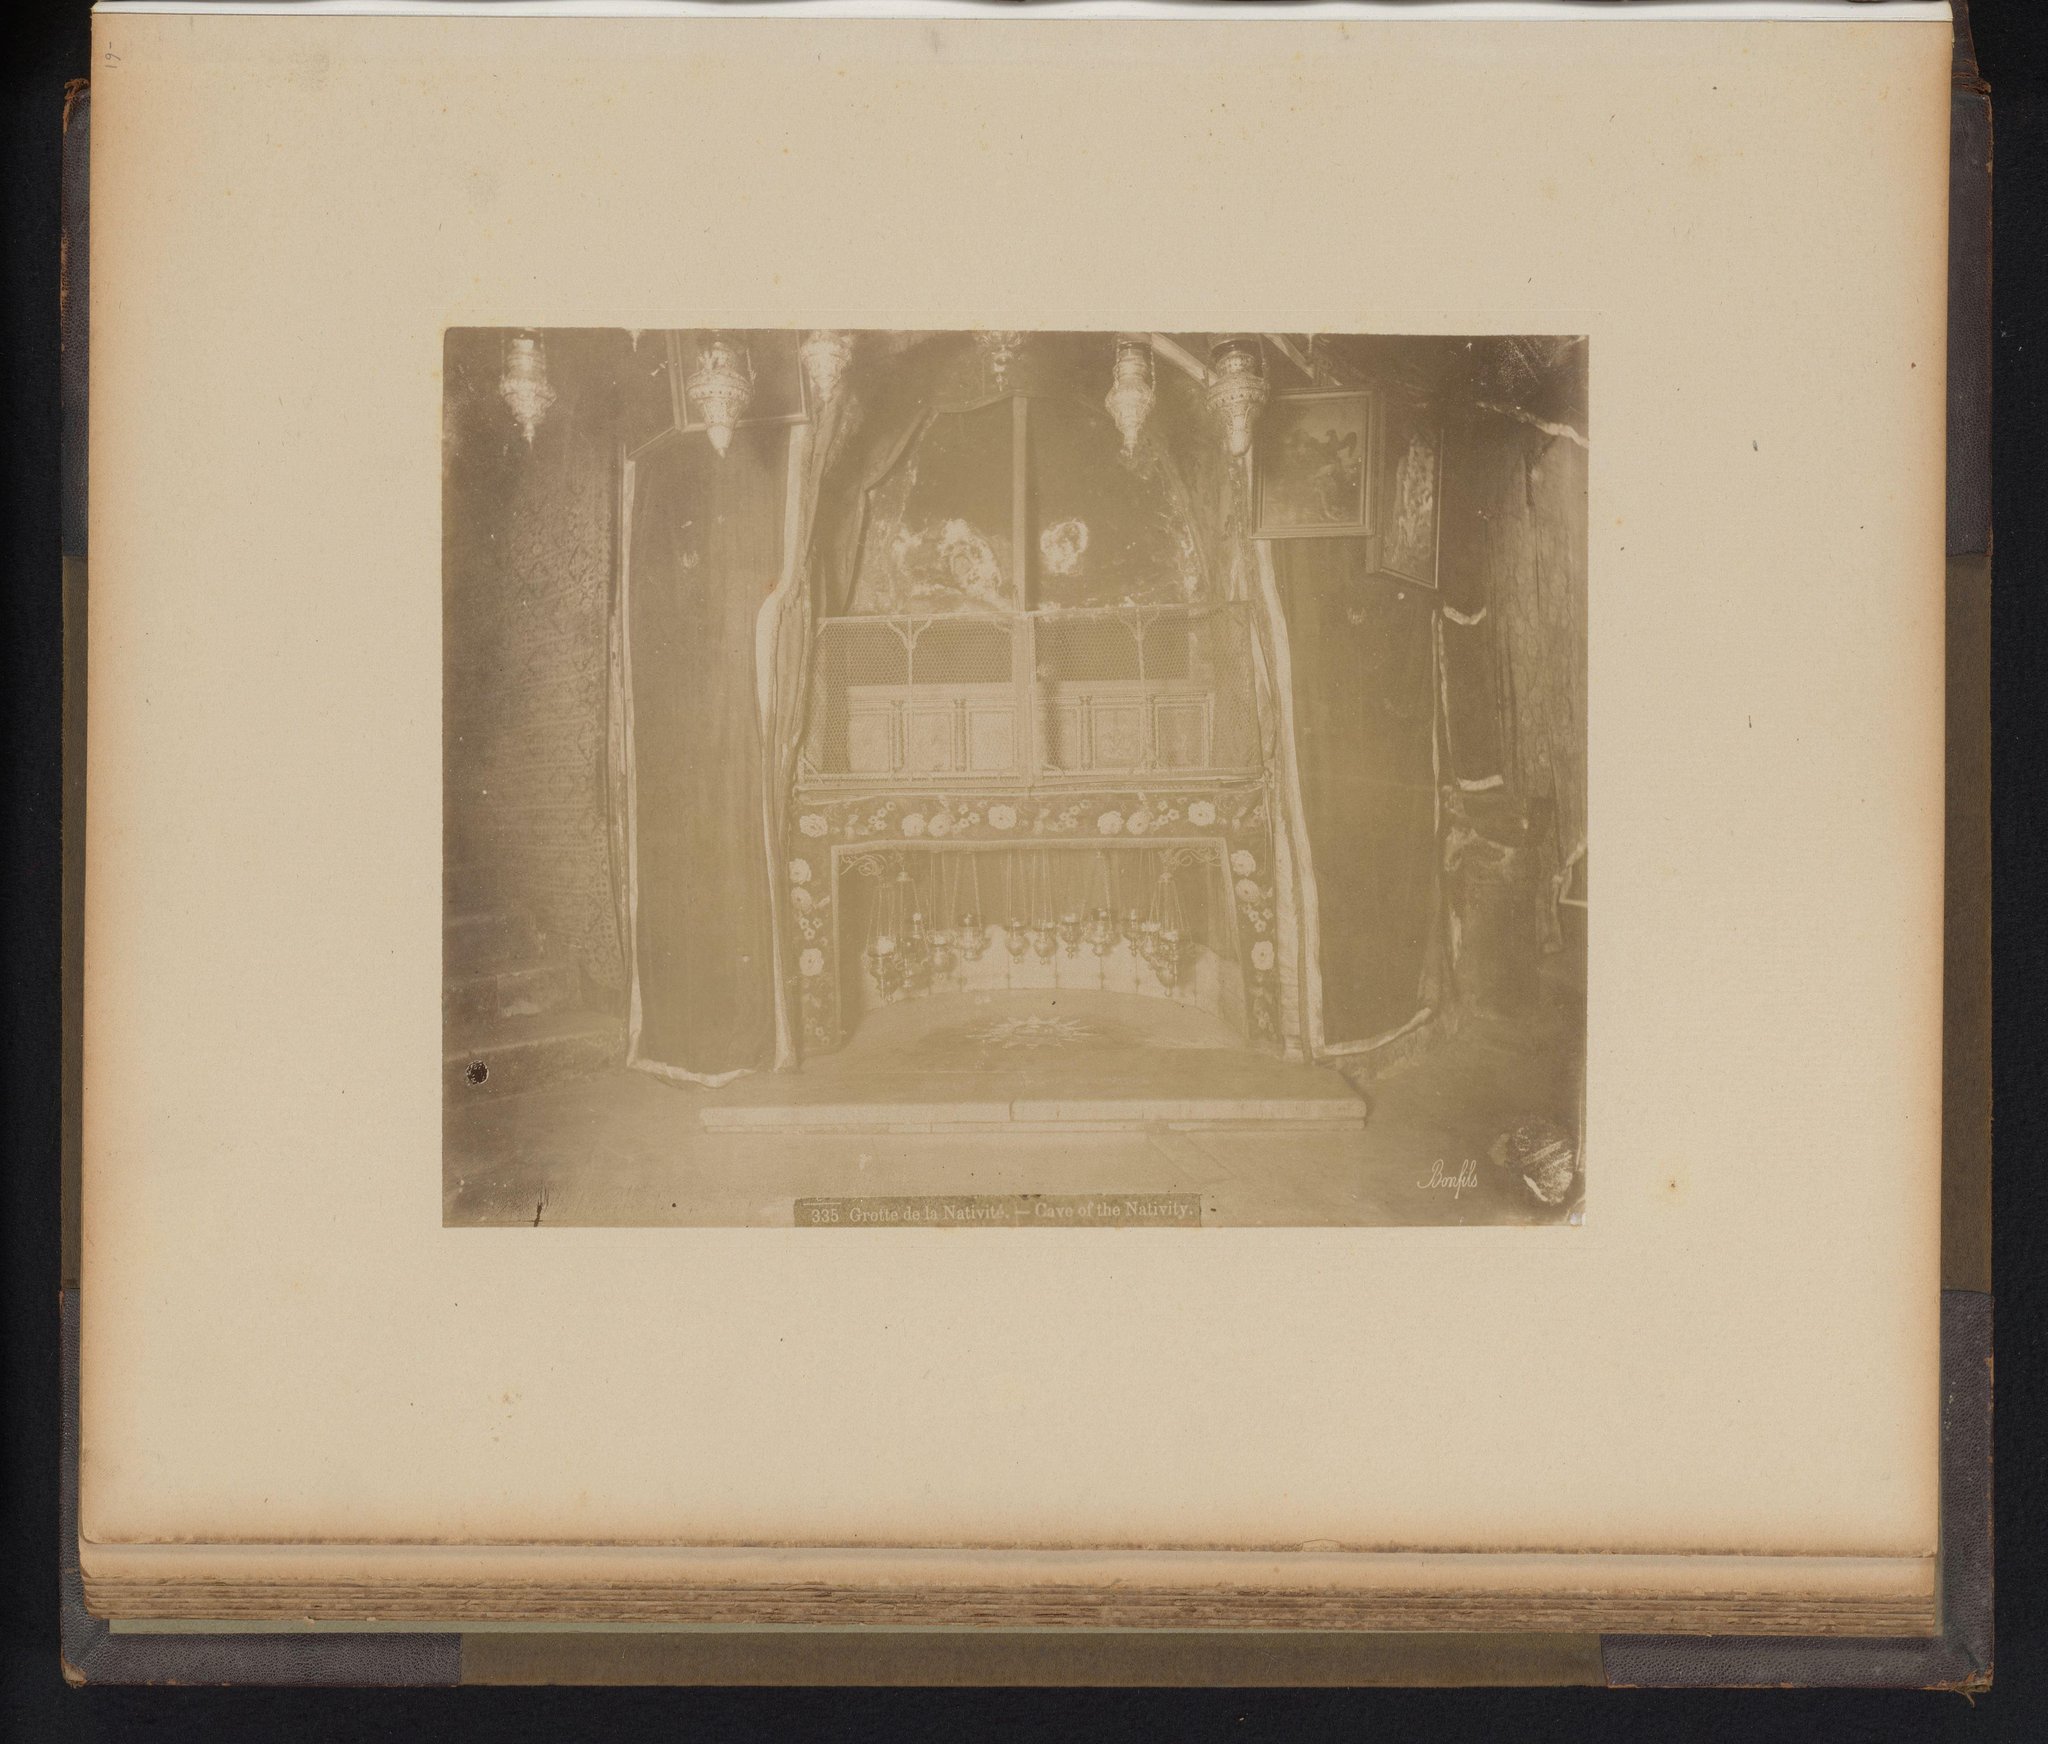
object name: photograph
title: Grotte de la Nativité / Cave of the Nativity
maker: félix bonfils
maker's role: fotograaf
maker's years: 1831-1885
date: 1867-1885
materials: paper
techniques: albumen print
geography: bethlehem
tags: interior of church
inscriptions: number: ‘335’